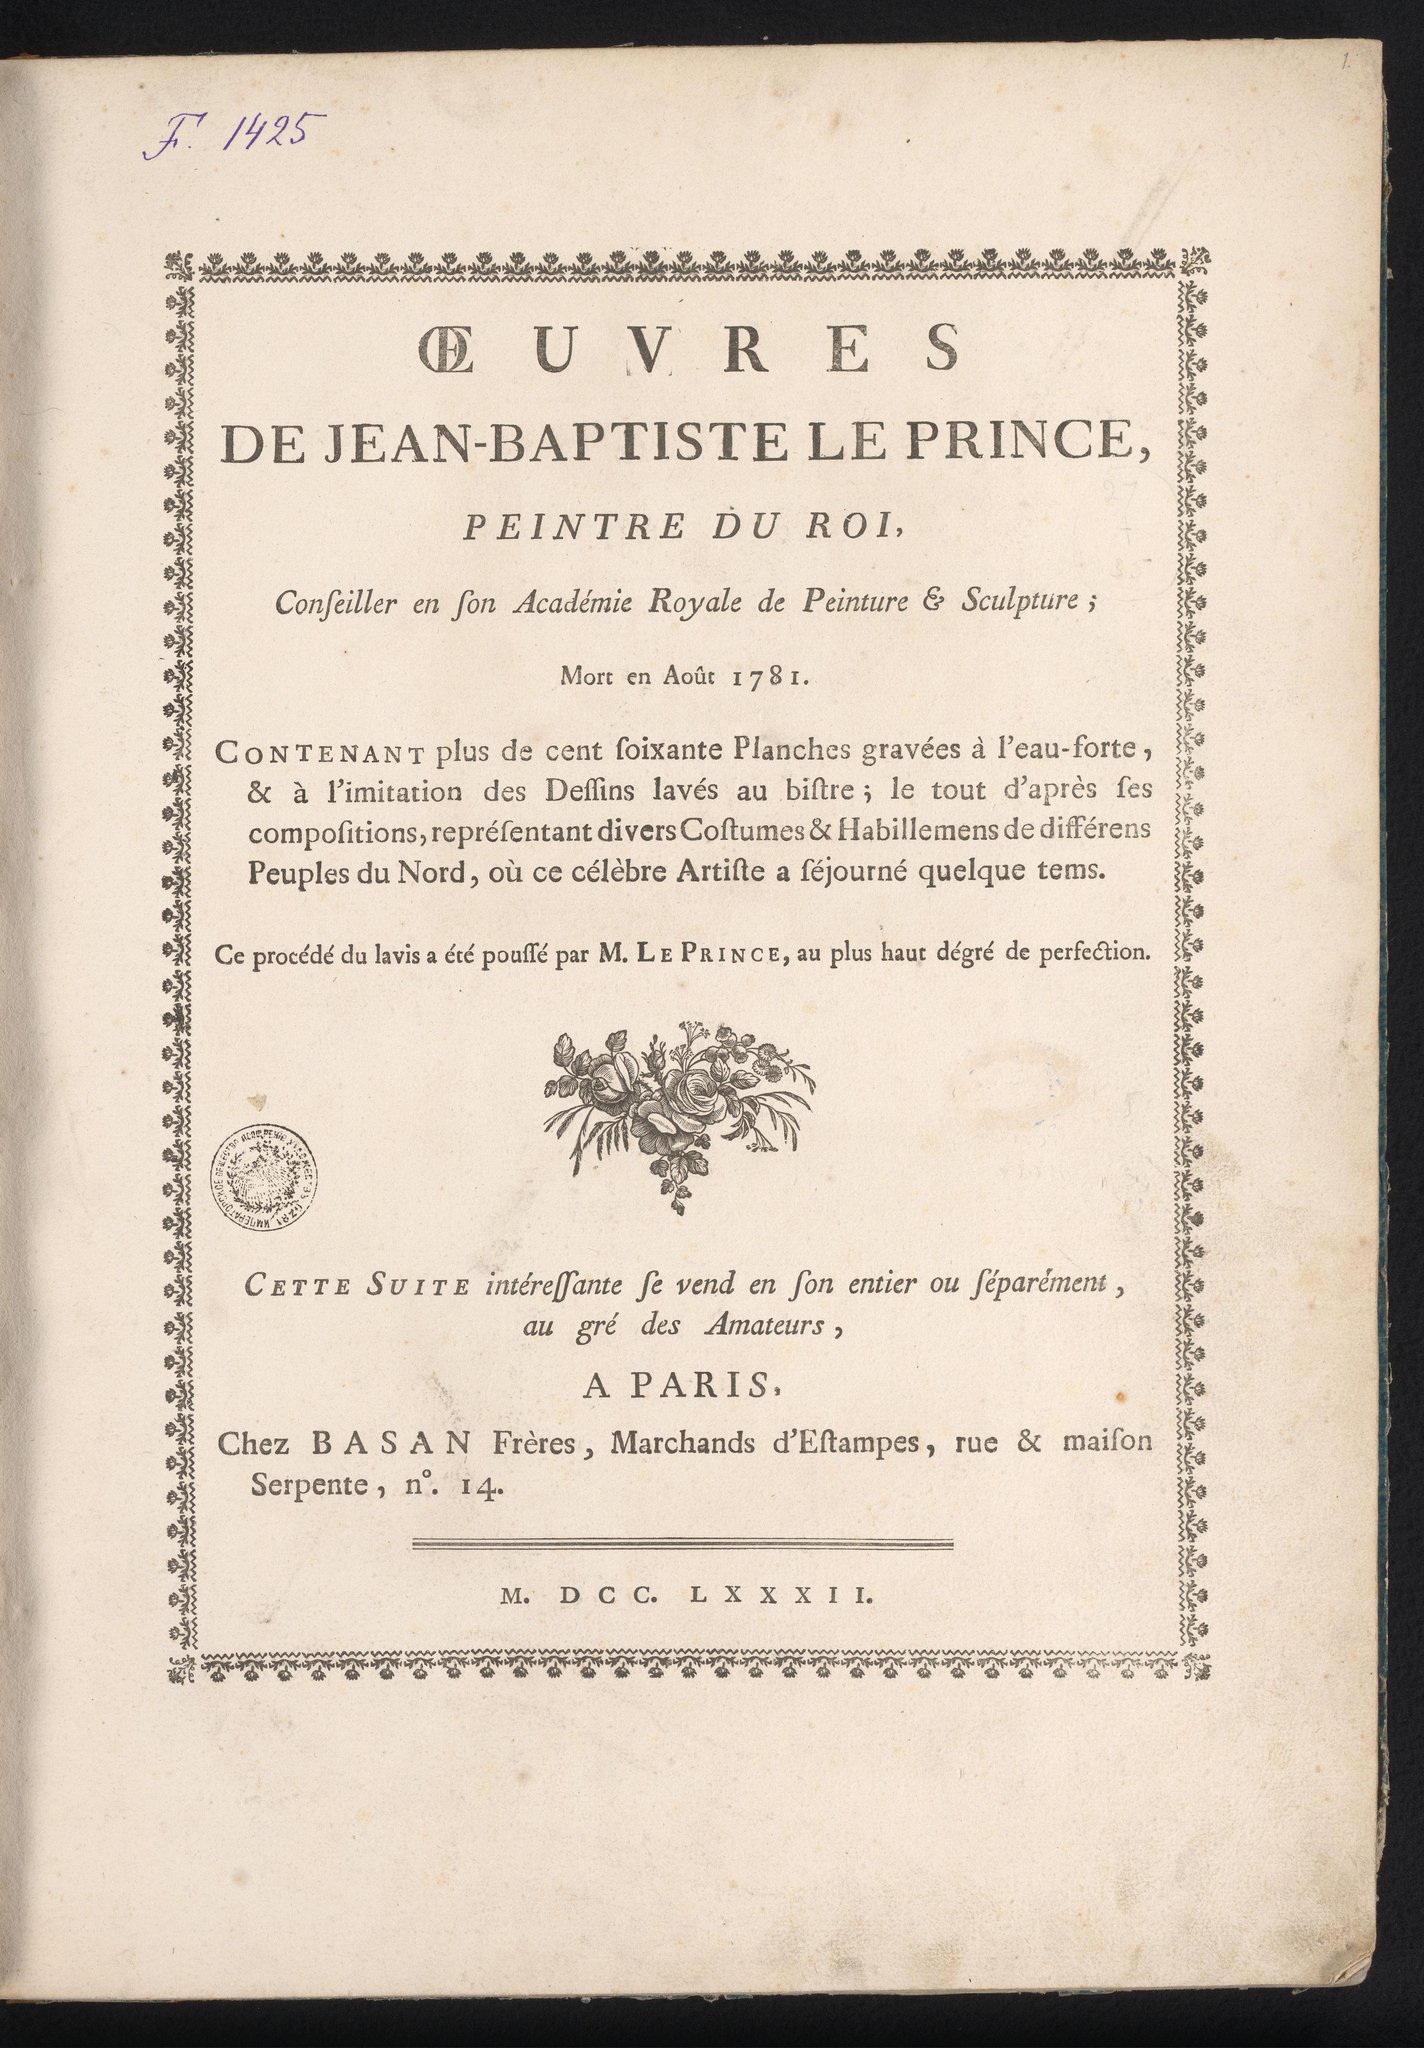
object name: print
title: Oeuvres de Jean-Baptiste Le Prince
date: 1782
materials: paper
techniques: letterpress printing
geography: paris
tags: flowers: rose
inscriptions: collector's mark: Lugt 2166, collector's mark: